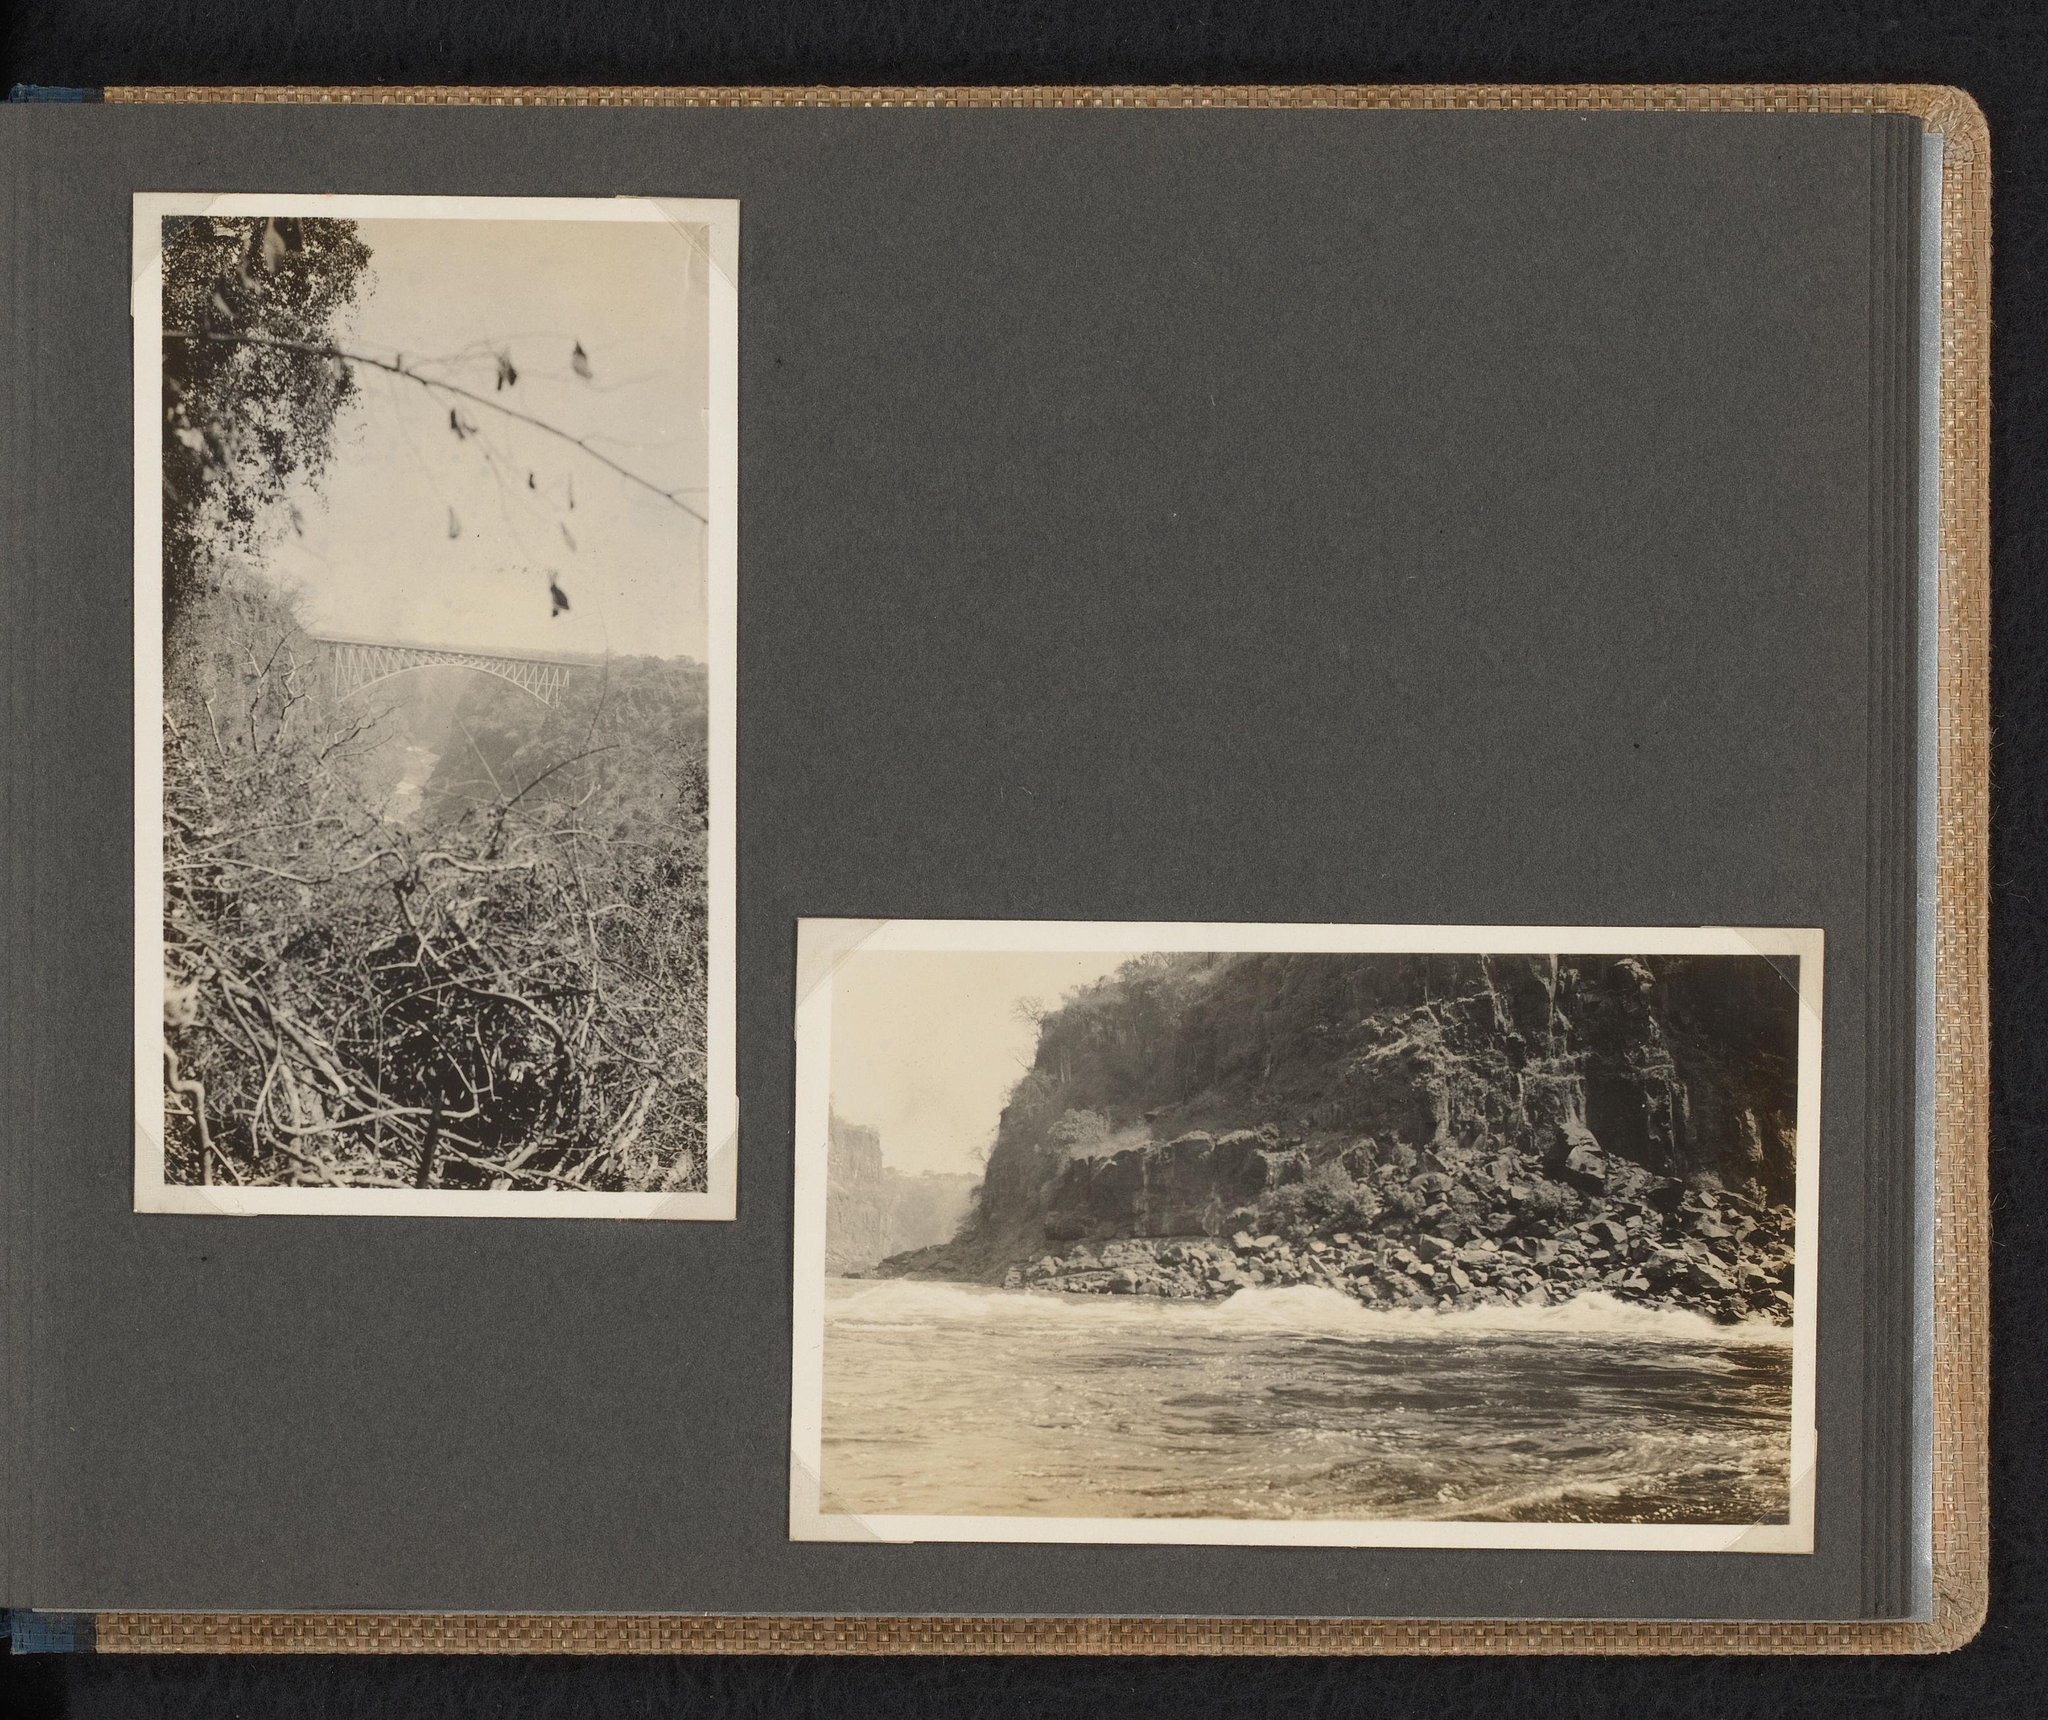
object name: photograph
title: Brug over een bergrivier in Zuid-Afrika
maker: karel frederik van den berg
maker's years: 1873-1948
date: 1920-1930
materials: paper, cardboard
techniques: gelatin silver print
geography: south africa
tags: bridge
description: Deze foto's zijn onderdeel van een album.